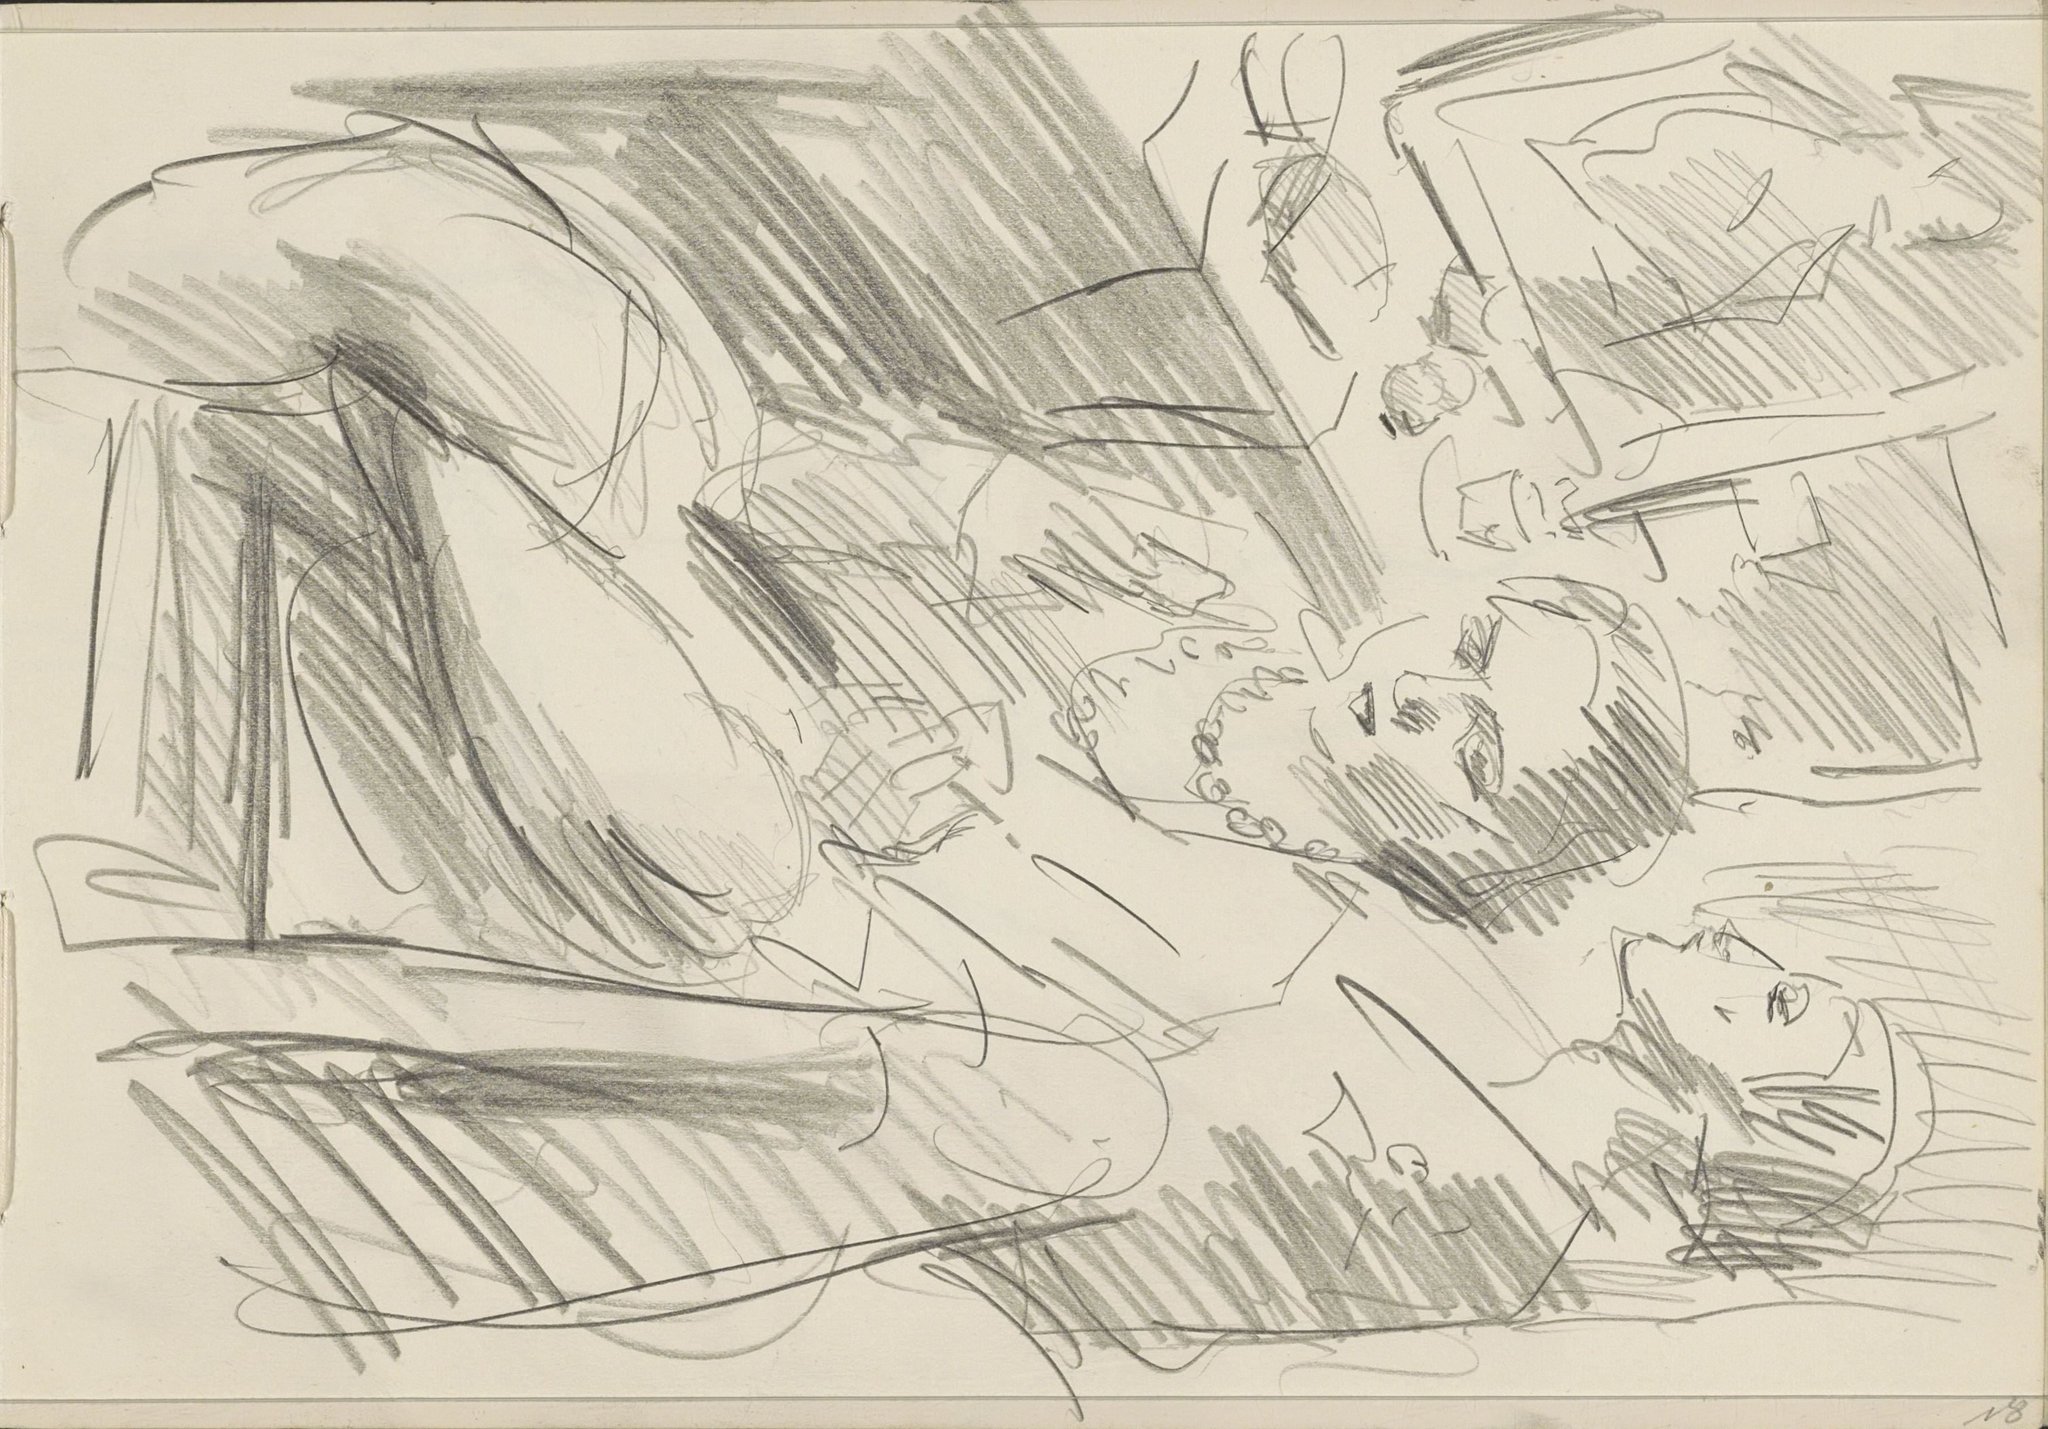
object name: sketchbook leaf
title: Twee vrouwen aan een toilettafel in een kleedkamer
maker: isaac israels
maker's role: draughtsman, painter, print maker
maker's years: 1865-1934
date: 1915-1934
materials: paper, pencil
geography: the hague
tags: making up - aa - (for) women, dressing-room ~ stage, mirror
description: Blad 18 recto uit schetsboek XXV met 23 bladen.